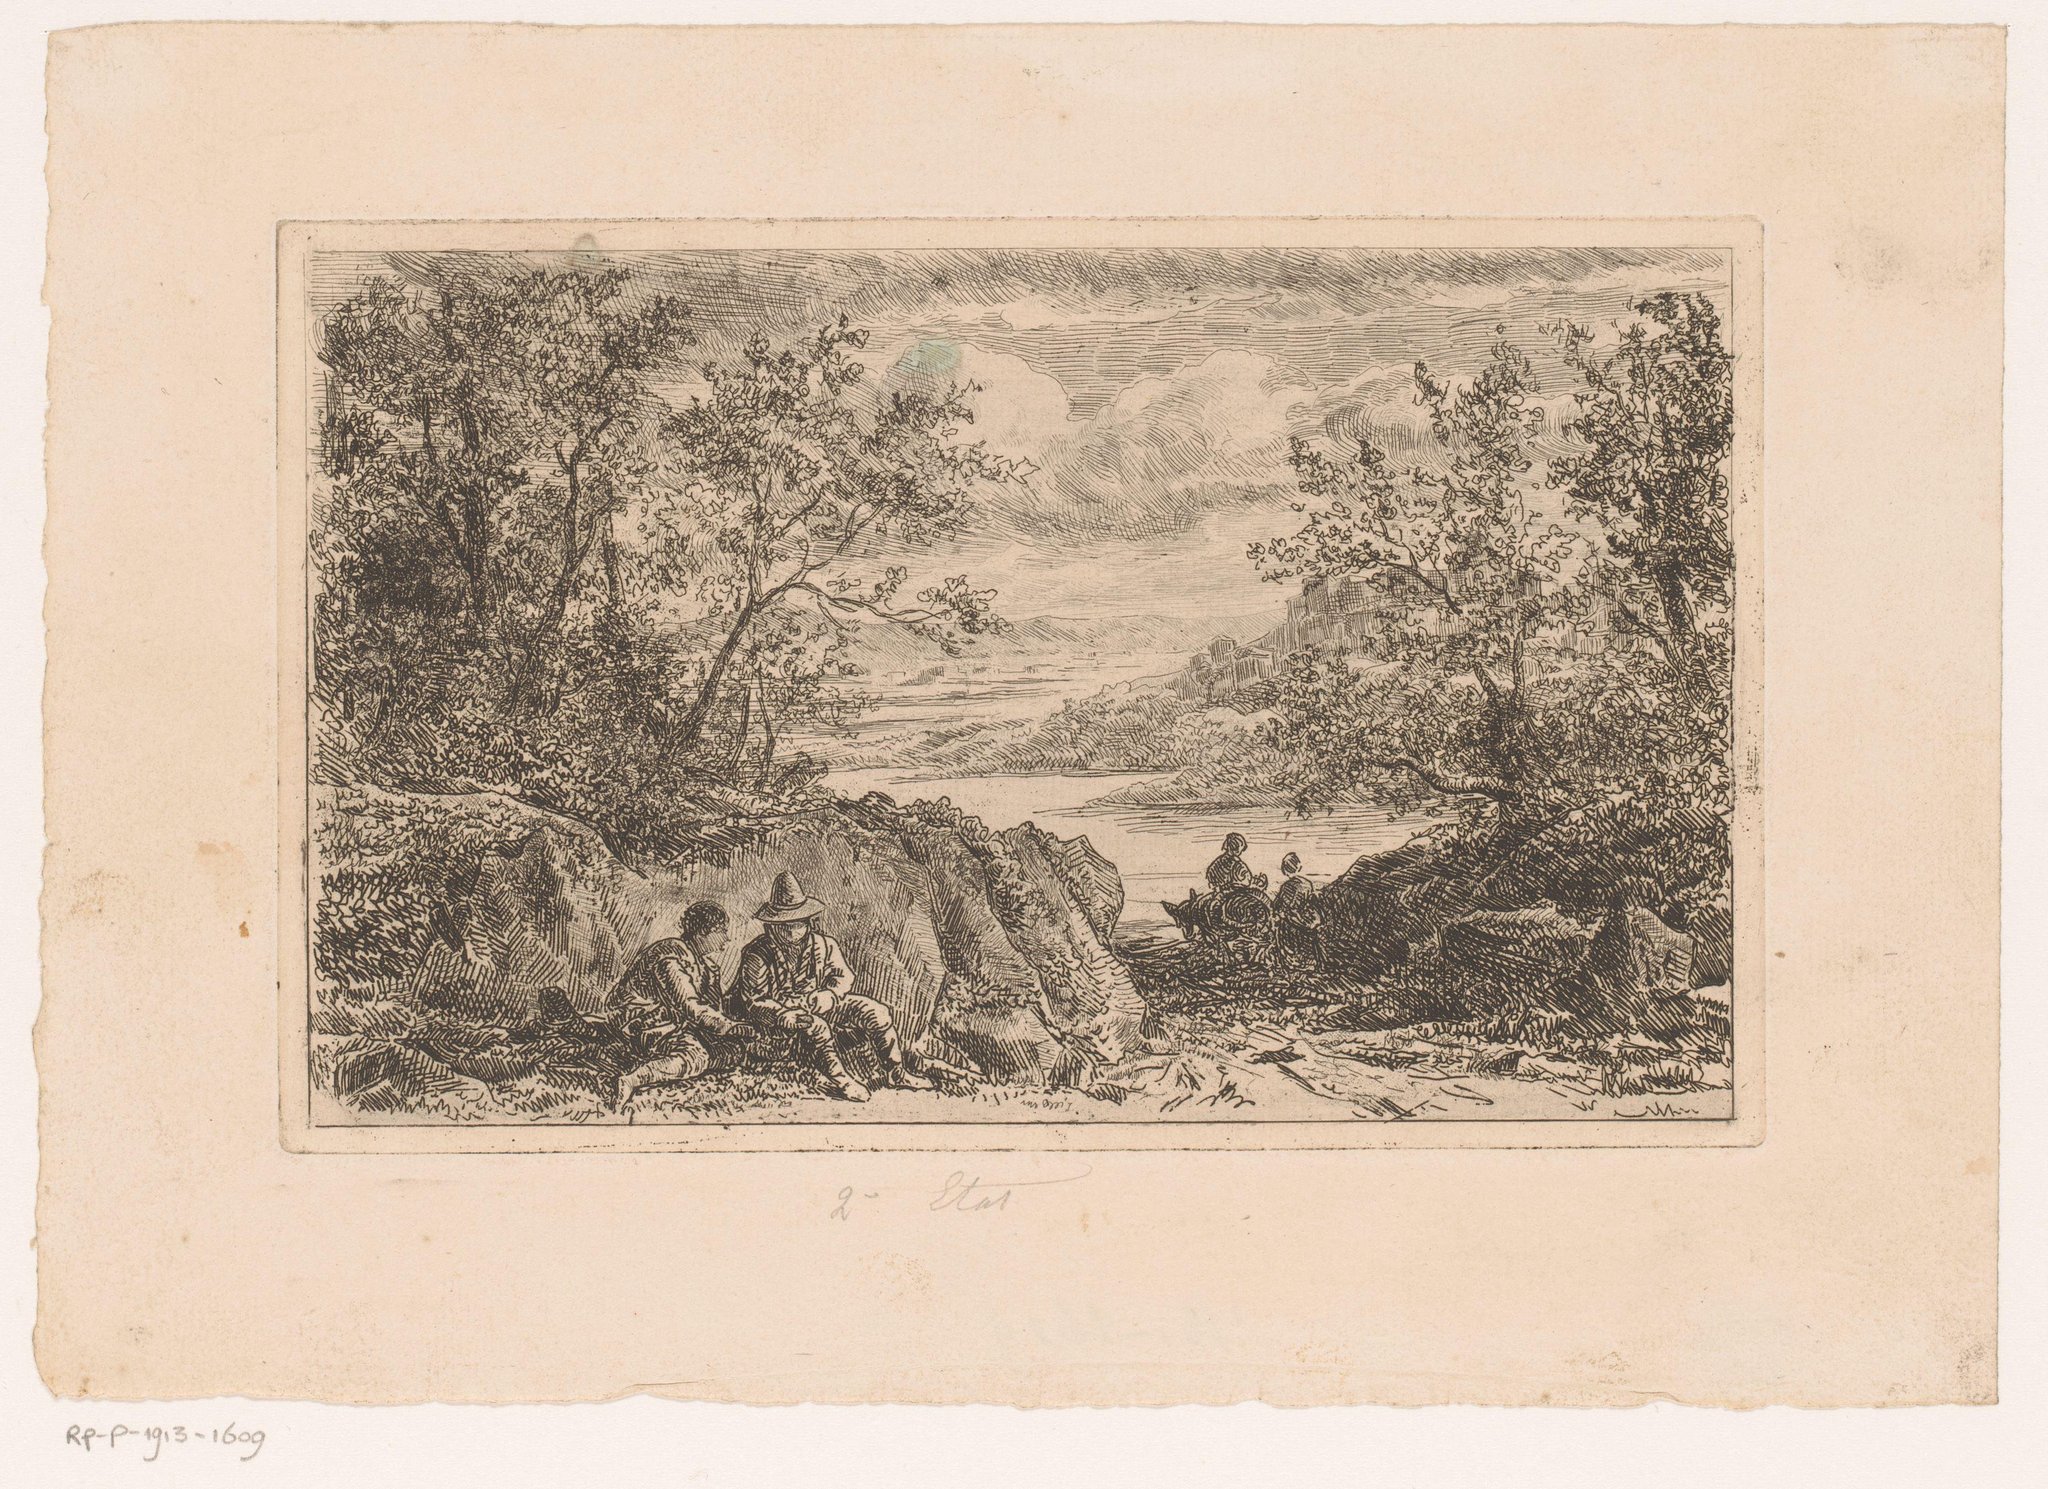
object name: print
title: Gezicht op het meer van Albano en Castel Gandolfo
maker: joseph meganck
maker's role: print maker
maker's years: 1807-1891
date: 1817-1888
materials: paper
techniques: etching, intaglio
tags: riding a horse, ass, or mule; rider, horseman, lake, city-view, and landscape with man-made constructions (+ city(-scape) with figures, staffage)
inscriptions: inscription: ‘2e Etat’, collector's mark: Lugt 2228